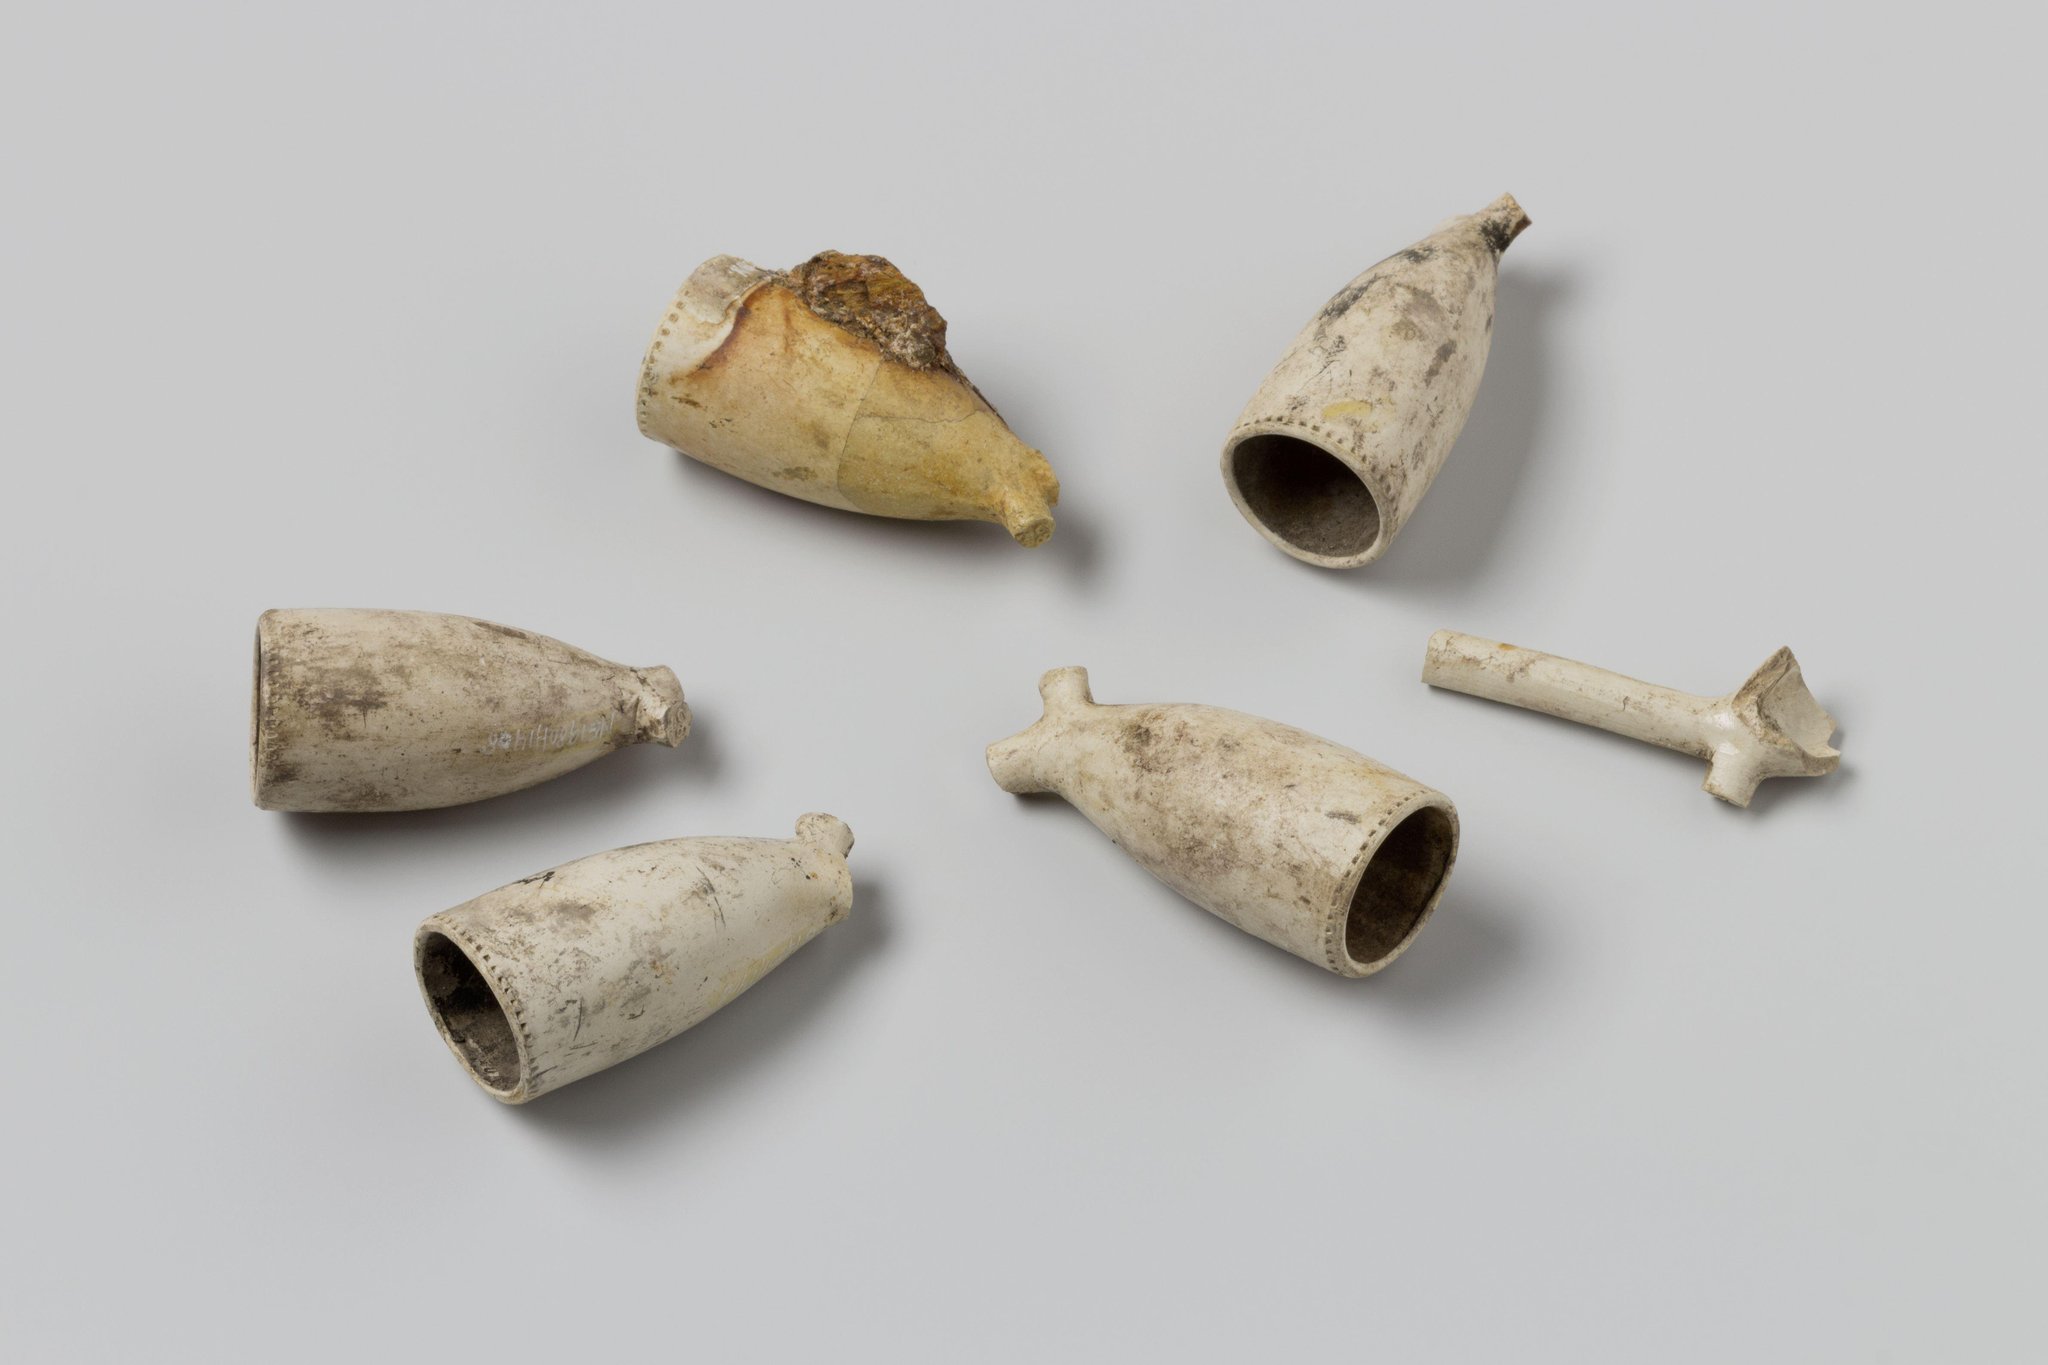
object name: pipe bowl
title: Pijpenkoppen en fragment pijpensteel uit het wrak van de Oost-Indiëvaarder Hollandia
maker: Anonymous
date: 1700-1743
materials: clay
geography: netherlands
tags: verenigde oostindische compagnie, hollandia (schip), annet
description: Pipe, bowl, heelmark: crowned 82; fragm, no hsm.